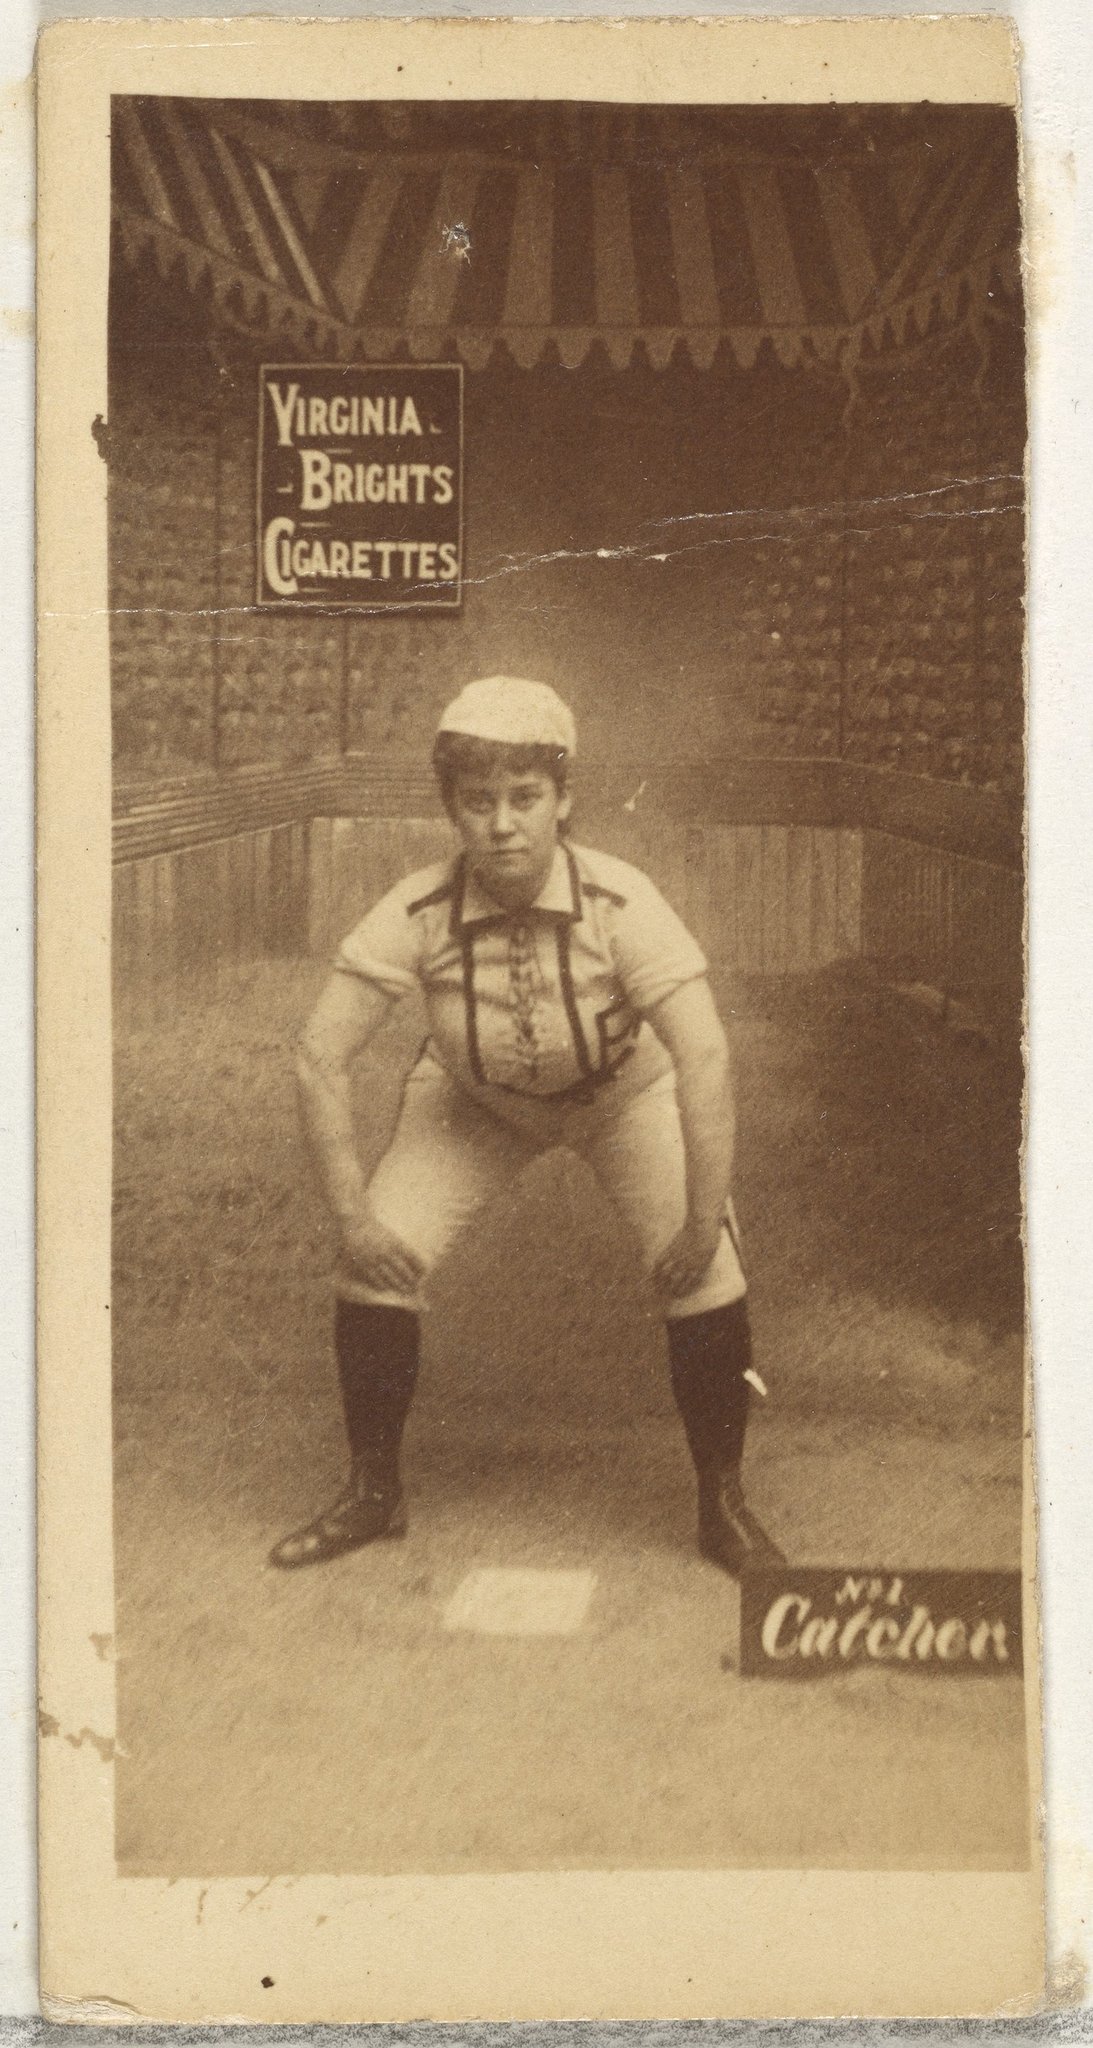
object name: baseball card, photograph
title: Catcher, from the Girl Baseball Players series (N48, Type 2) for Virginia Brights Cigarettes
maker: allen & ginter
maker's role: publisher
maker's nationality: american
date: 1886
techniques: albumen silver print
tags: portraits,women,baseball,athletes